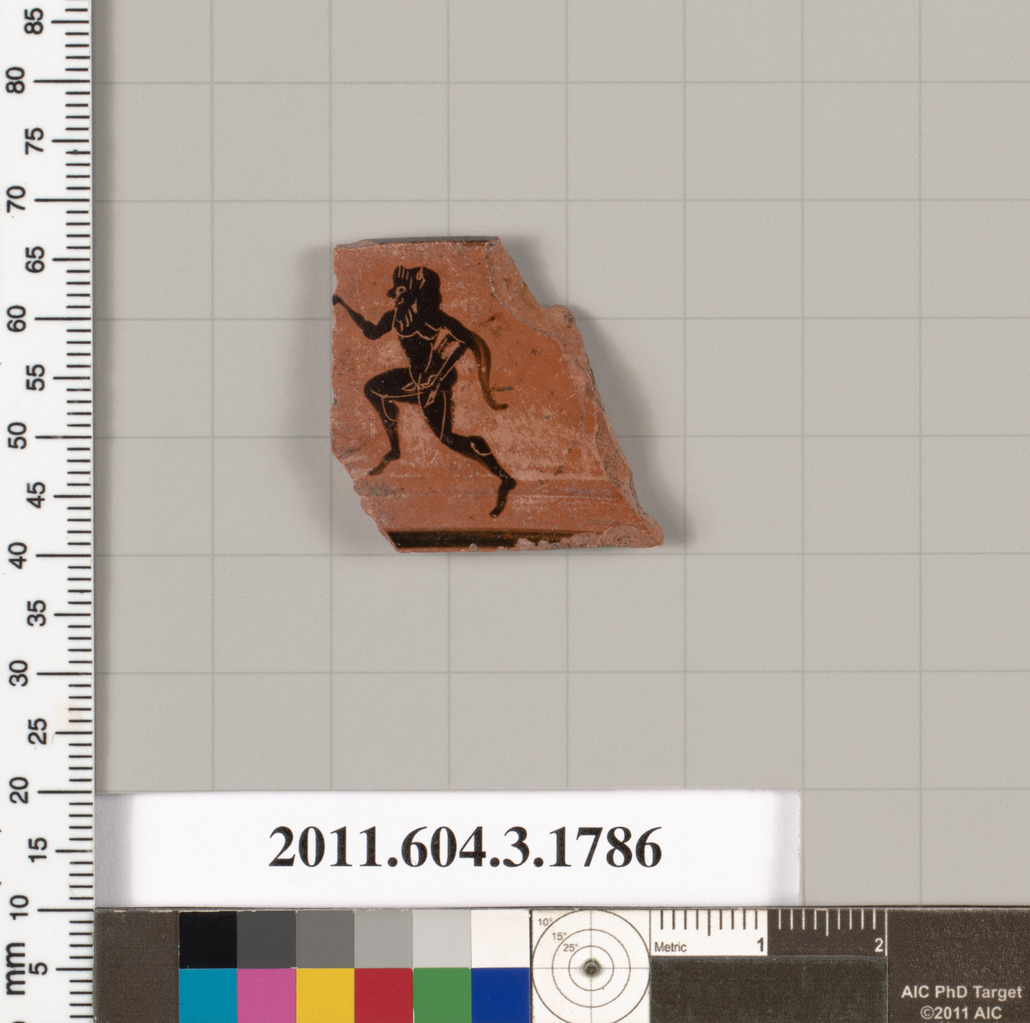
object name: kylix fragment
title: Terracotta rim fragment of a kylix: Lip cup (drinking cup)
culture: greek, attic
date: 550-530 BCE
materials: terracotta